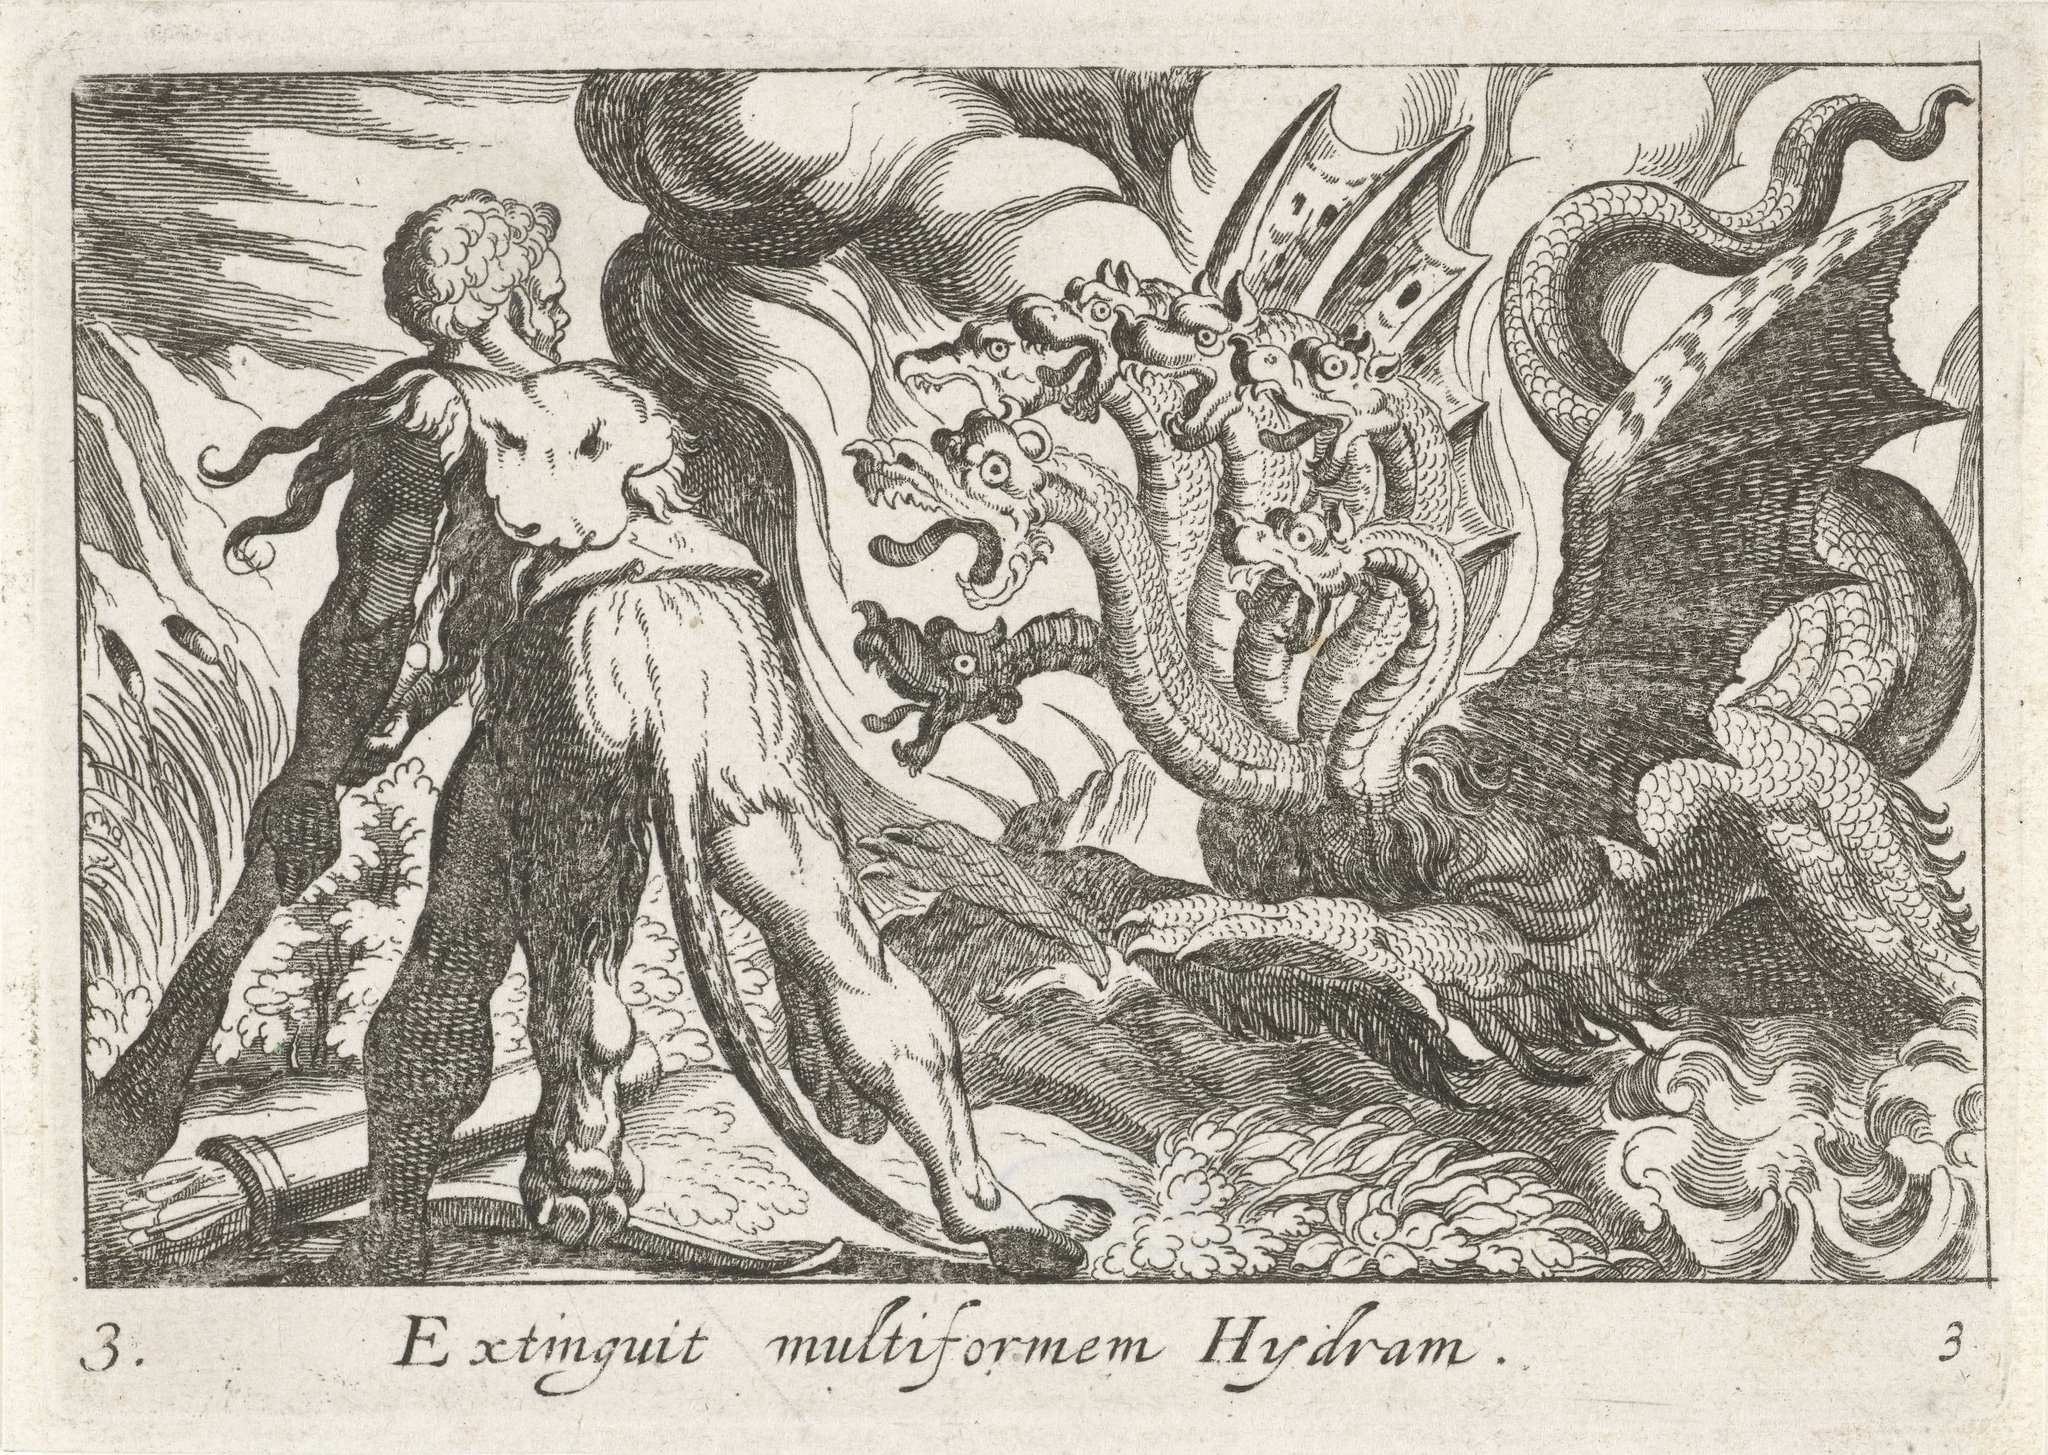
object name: print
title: Extinguit multiformen Hydram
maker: simon frisius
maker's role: print maker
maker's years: 1570-1628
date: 1610-1664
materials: paper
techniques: etching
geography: italy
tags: (2) the hydra of lerna is killed by hercules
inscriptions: collector's mark: Lugt 2228